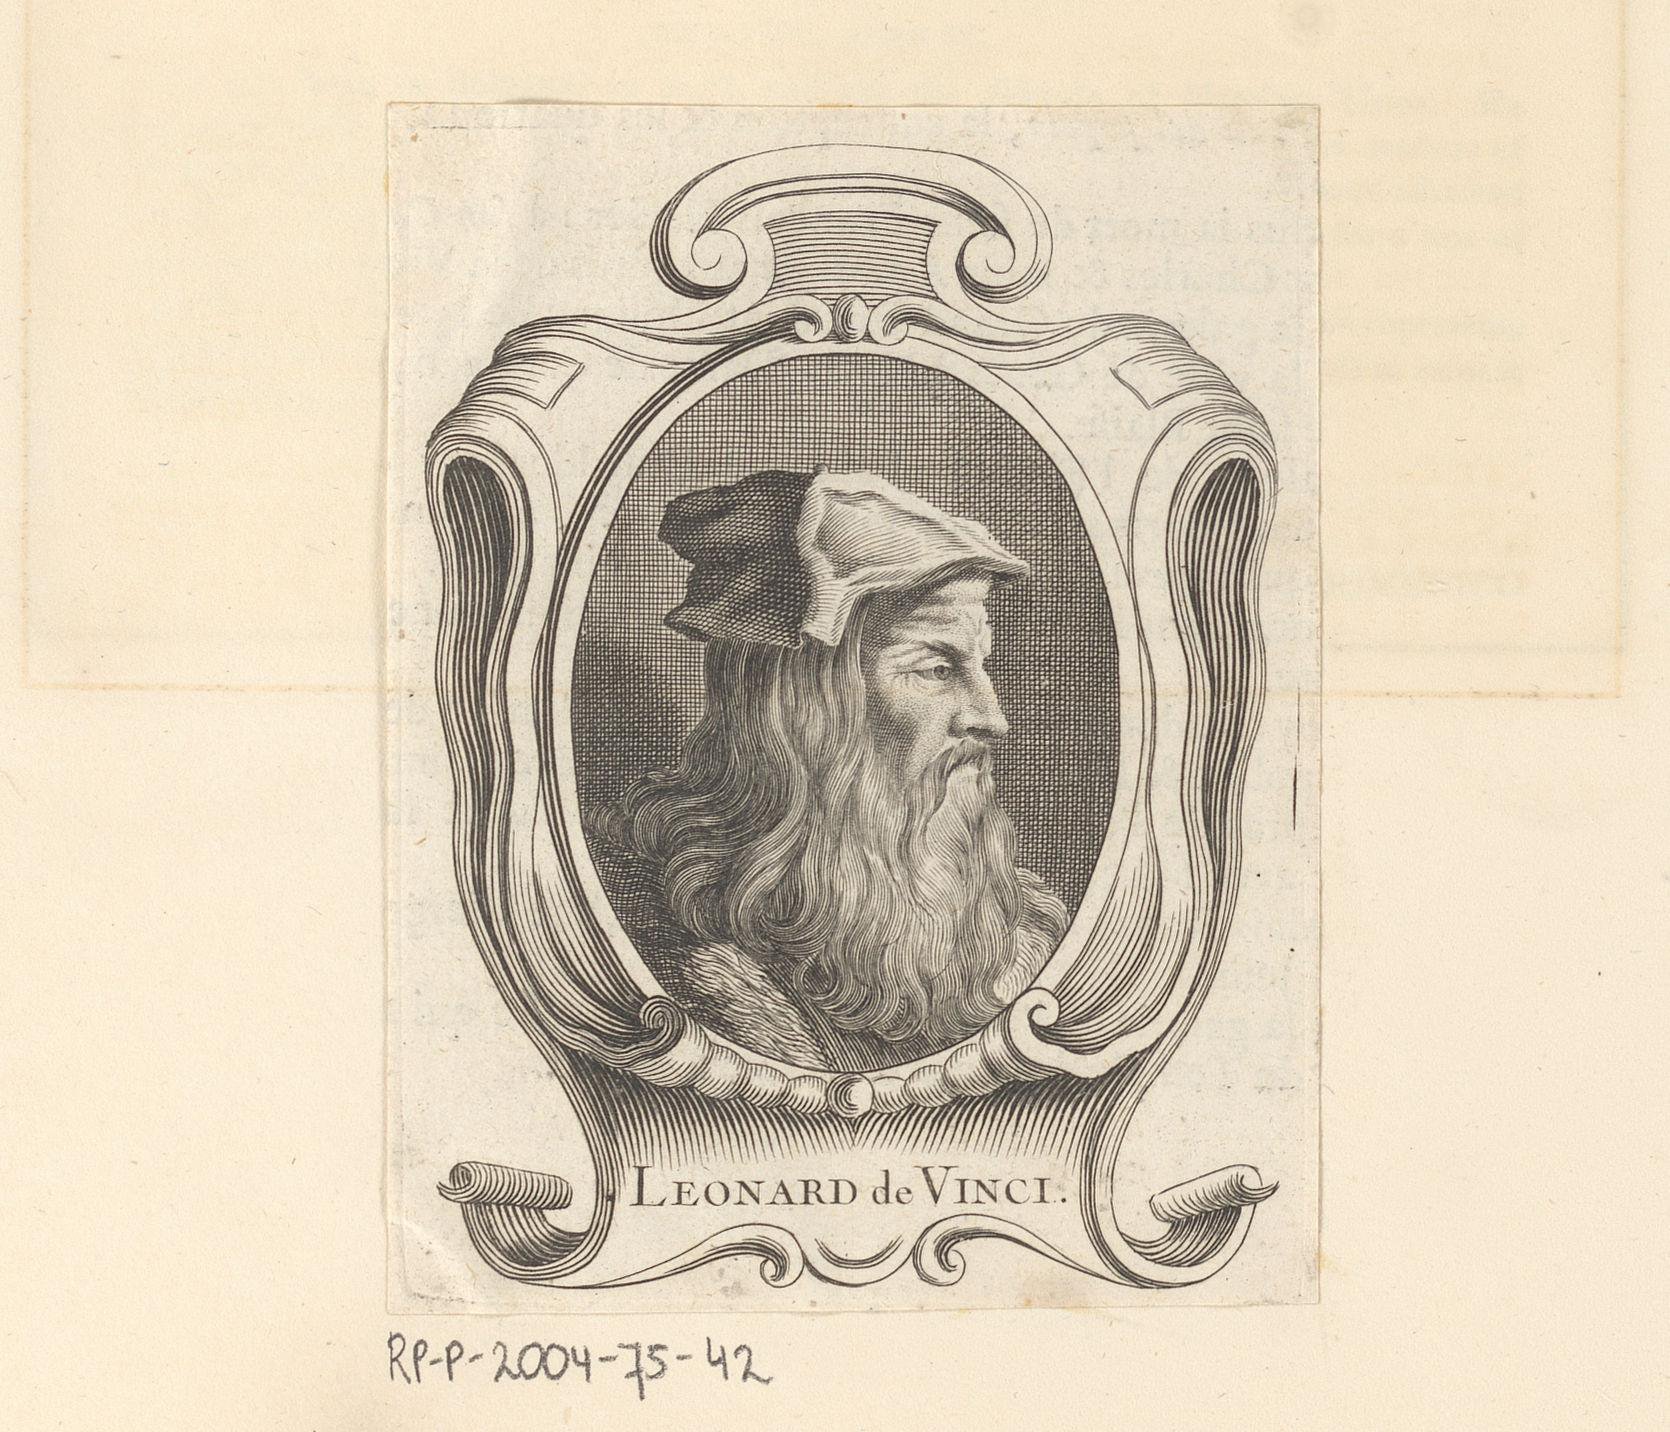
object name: print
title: Portret van Leonardo da Vinci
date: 1745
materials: paper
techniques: engraving, letterpress printing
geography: paris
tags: artist, leonardo da vinci, historical persons, portrait, self-portrait of painter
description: Prent uit: Dézallier d'Argenville, Antoine Joseph. Abrégé de la vie des plus fameux peintres. 4 dln. Parijs: De Bure l'aîné, 1745, dl. 1, p. 72. De samensteller heeft deze prent in het album geplakt als illustratie bij: Pilkington, Matthew en Johann Heinrich Füssli. A dictionary of painters, from the revival of the art to the present period. 4 dln. Londen: John Crowder, 1805, dl. 4, p. 619.